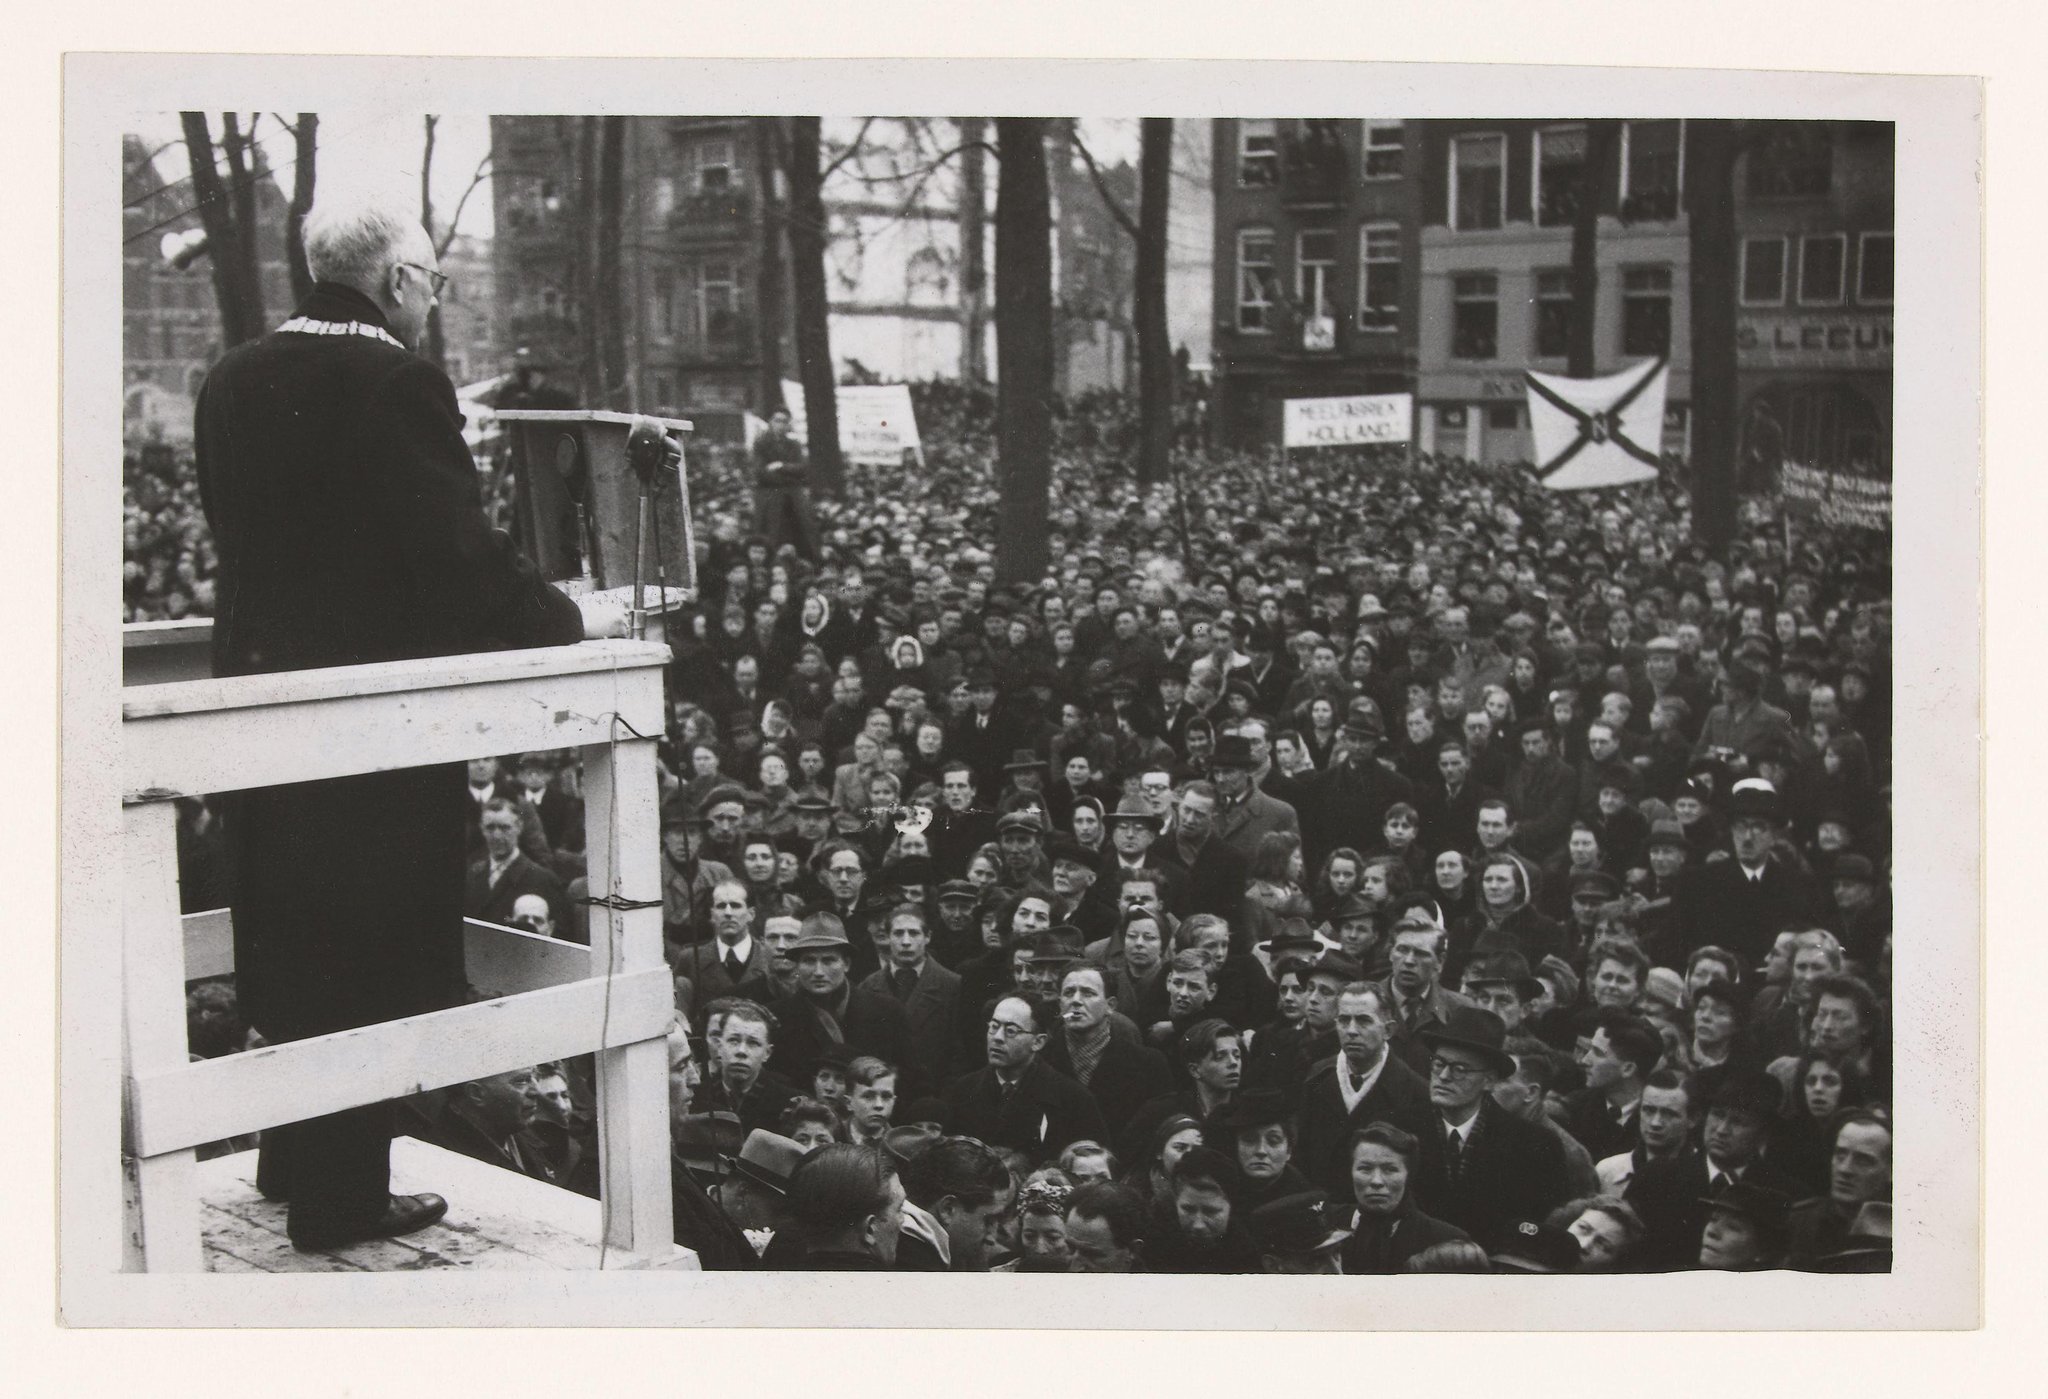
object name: documentary photograph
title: Herdenking Februari-staking op het Waterlooplein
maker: charles breijer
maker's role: fotograaf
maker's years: 1914-2011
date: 1946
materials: photographic support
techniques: photography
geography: amsterdam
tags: amsterdam, politician, mayor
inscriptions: number: ‘15142’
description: De Amsterdamse burgemeester Feike de Boer spreekt een menigte toe tijdens de eerste herdenkingsbijeenkomst van de februari-staking op het Waterlooplein.